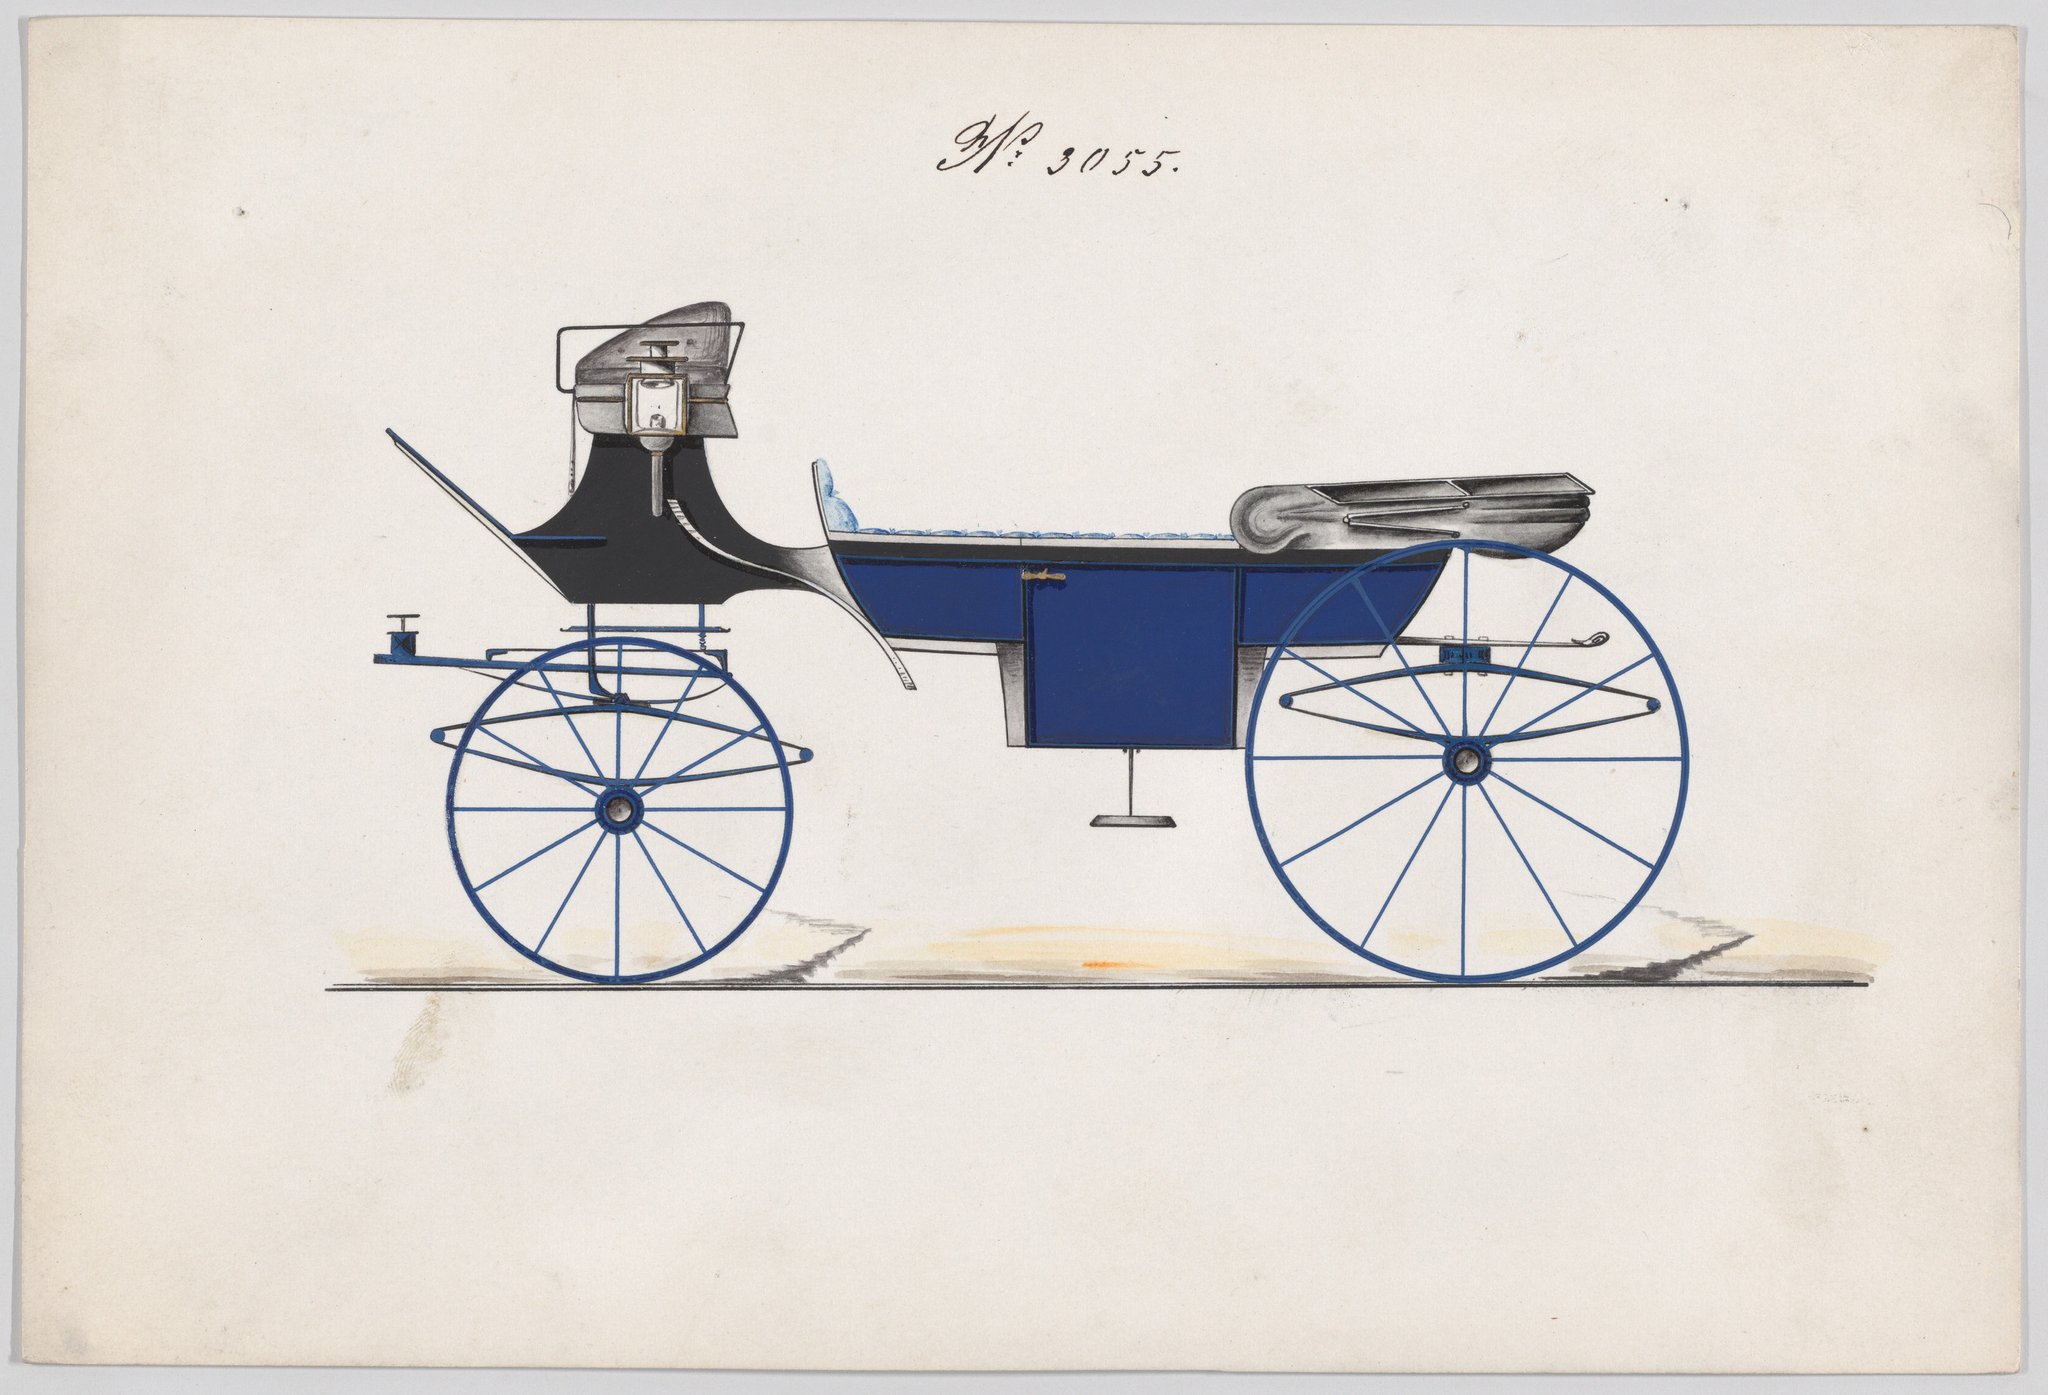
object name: drawing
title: Vis-à-vis #3055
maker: brewster & co.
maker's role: manufacturer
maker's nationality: american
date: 1874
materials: gouache, gum arabic, ink, watercolor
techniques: pen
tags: carriages